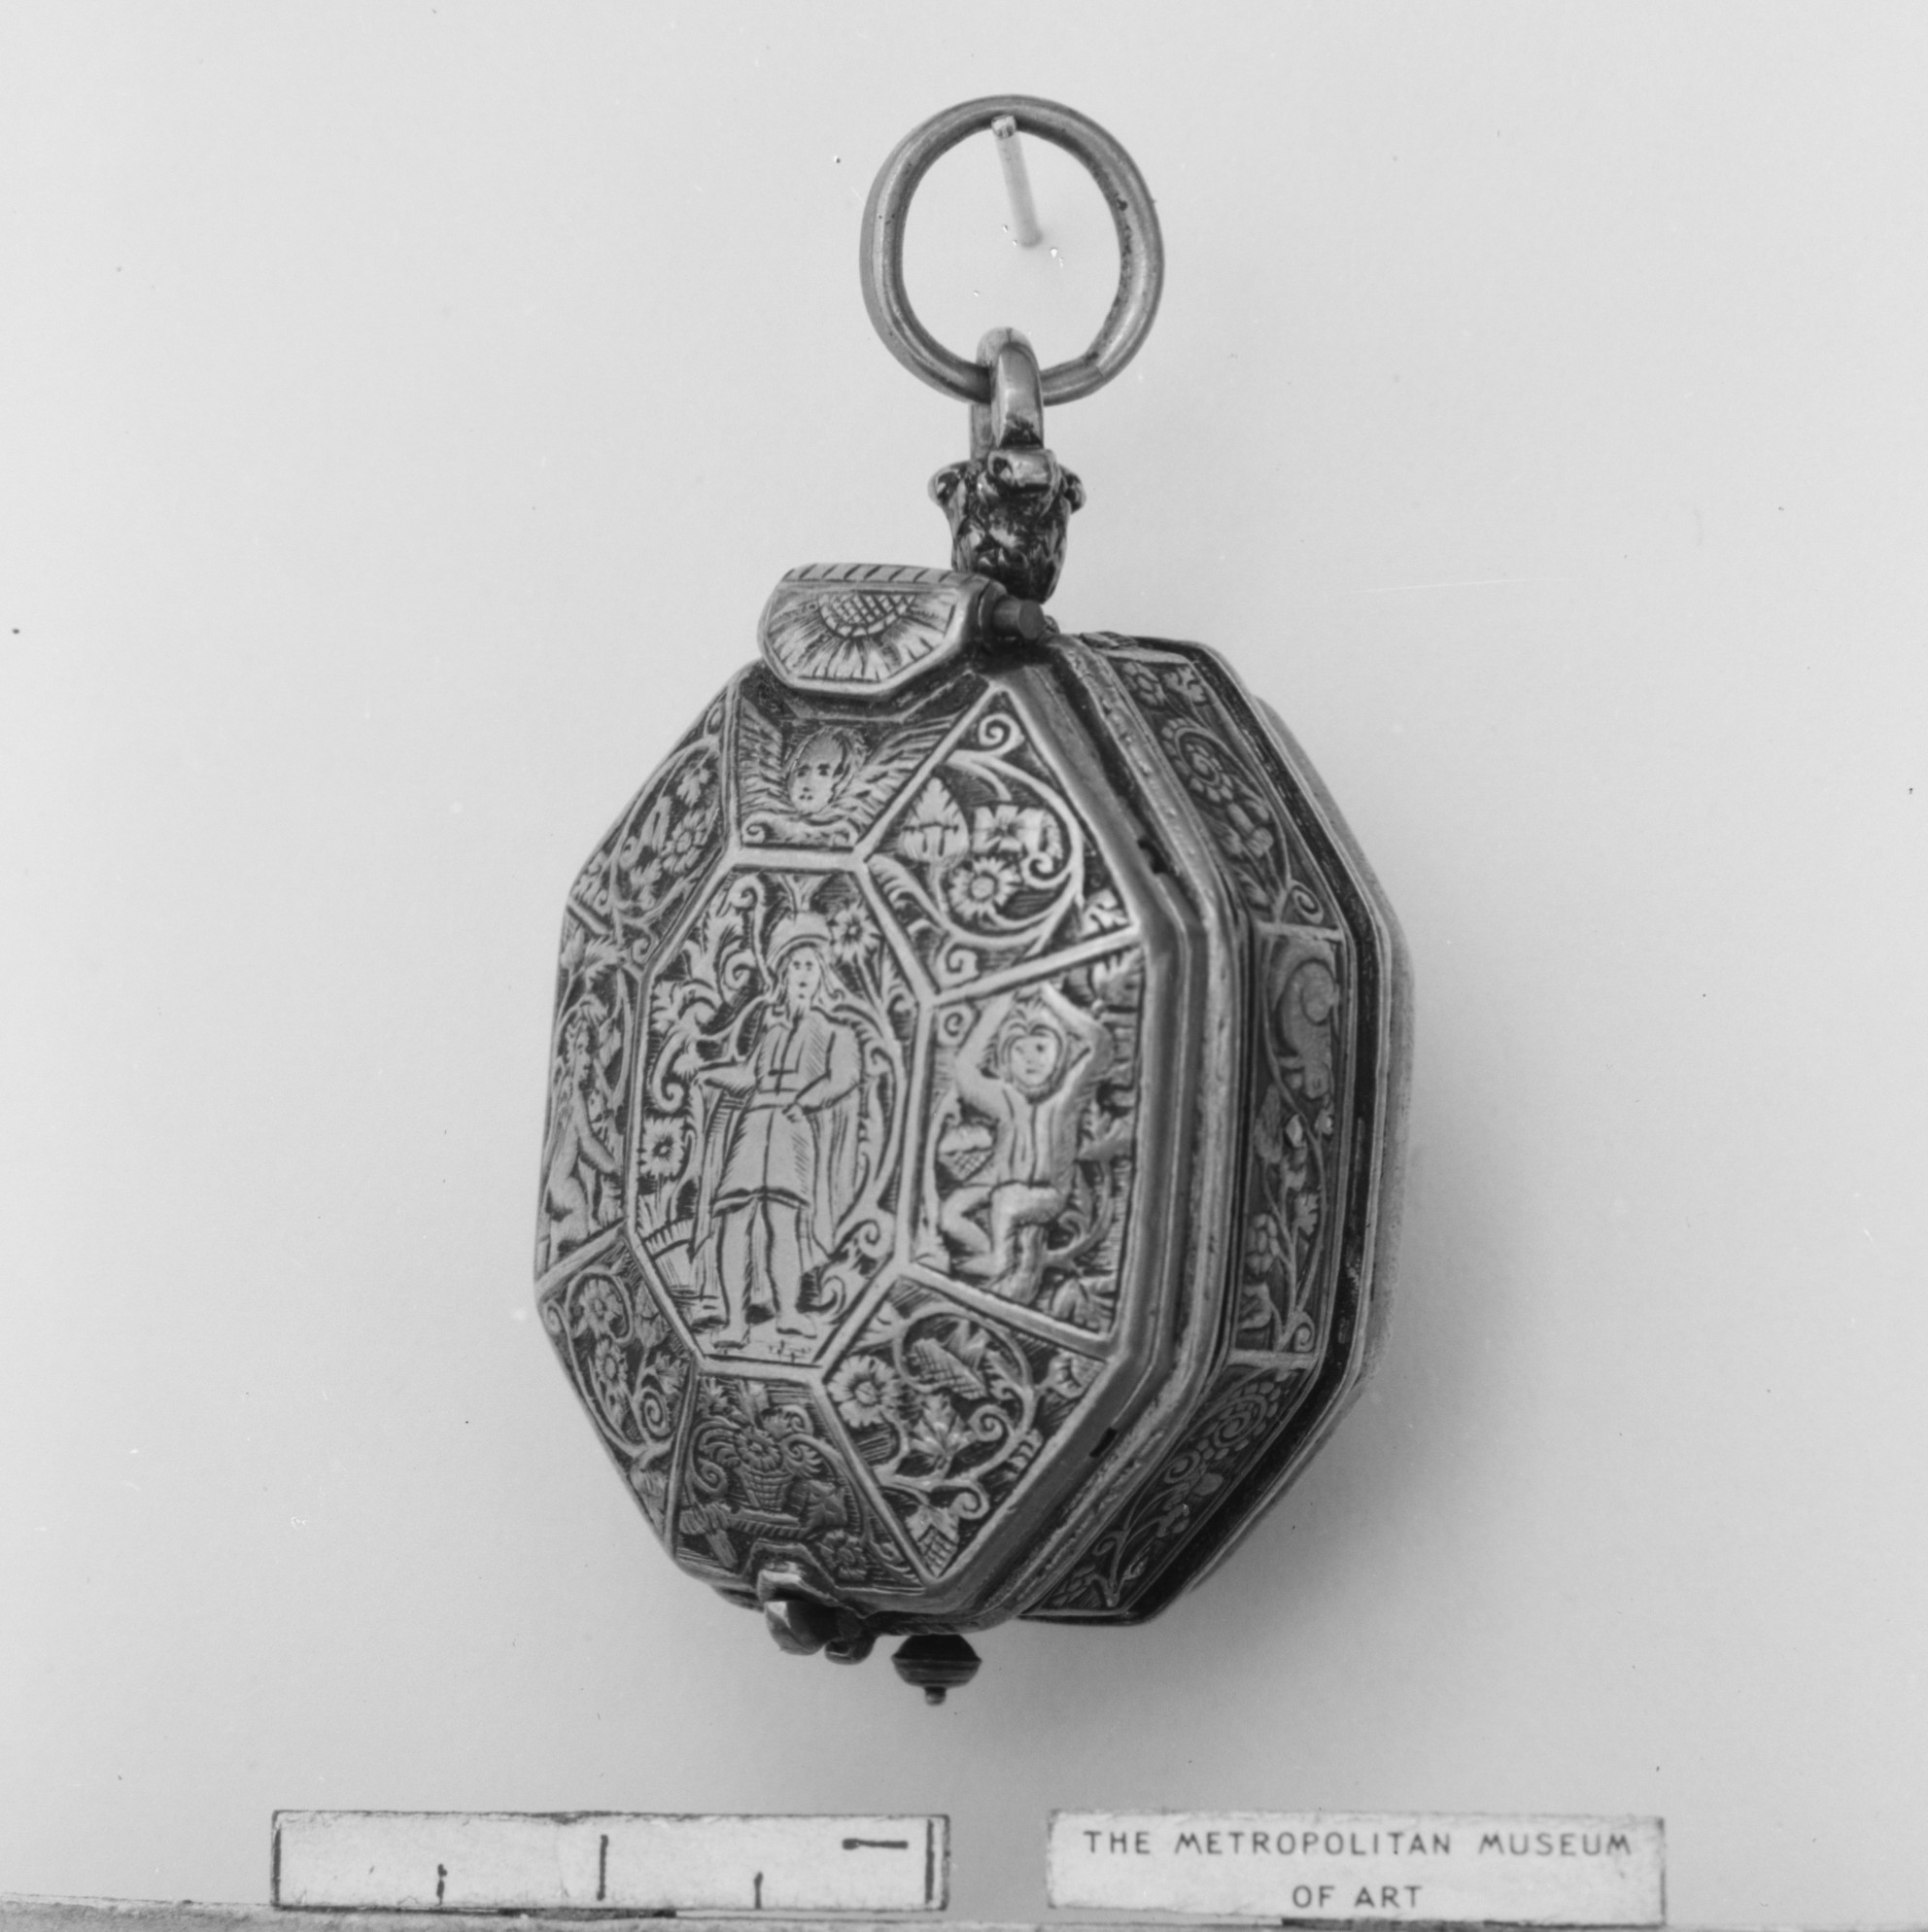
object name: watch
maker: judith lalement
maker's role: maker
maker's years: 1660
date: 1660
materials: metal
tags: faces,men,flowers